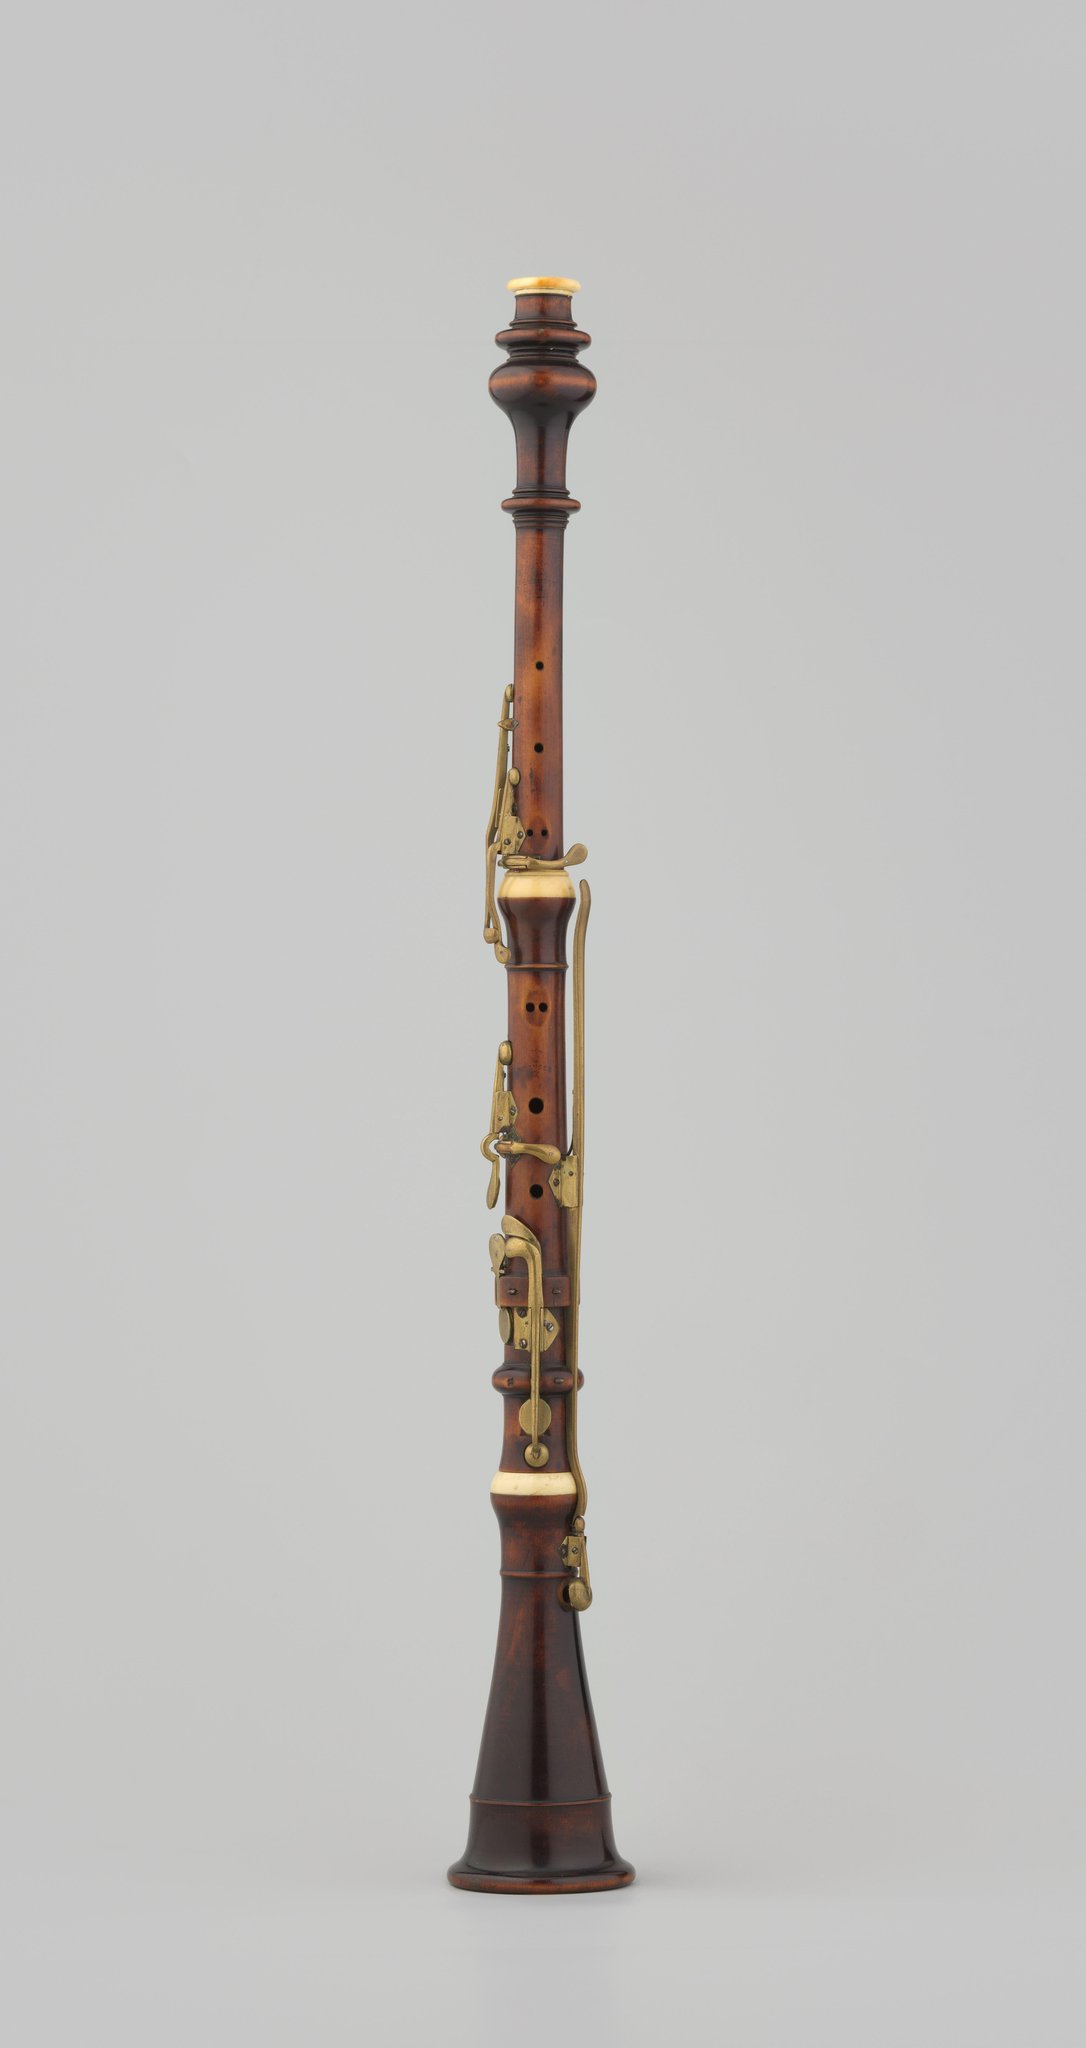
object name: oboe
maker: christoph delusse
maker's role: musical instrument maker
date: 1780-1800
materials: wood, brass, ivory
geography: paris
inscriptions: mark: ‘[kroon] / C / DELUSSE / #.’, inscription: ‘3’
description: Hobo van palmhout met negen messing kleppen. Enkele kleppen (met zadeltjes) zijn er zeer waarschijnlijk opgezet door Guillaume Triébert. Het derde en vierde gat zijn dubbel. Gemarkeerd op alle drie de delen met: [kroon] / C / DELUSSE / #. Op het bovenste gedeelte is de hobo gemarkeerd met het cijfer 3.